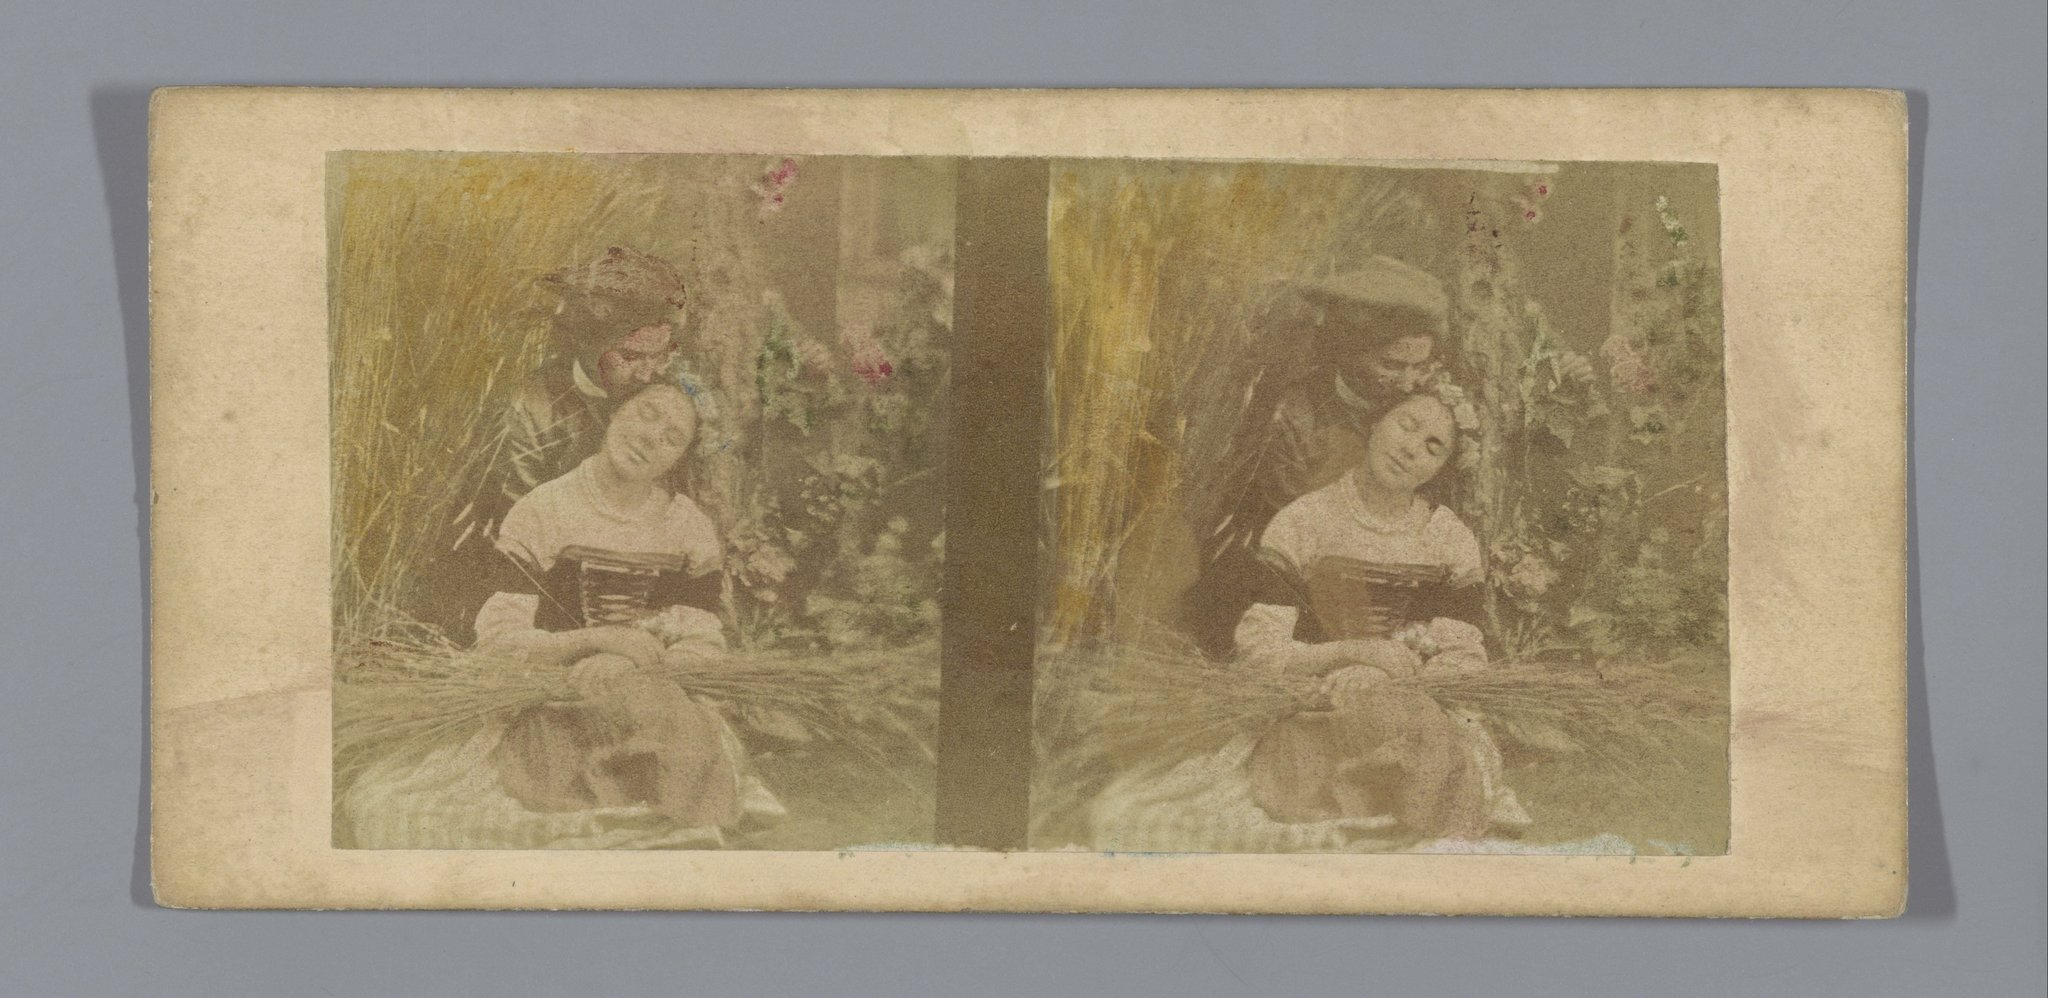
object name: stereograph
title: Theatrale voorstelling van een man en vrouw in historische kostuums, de man kust de vrouw op haar hoofd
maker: Anonymous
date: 1850-1880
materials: cardboard, photographic support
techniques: albumen print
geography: europe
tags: (lovers) kissing each other, historical costume, couple of lovers, europe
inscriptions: number: ‘K9’